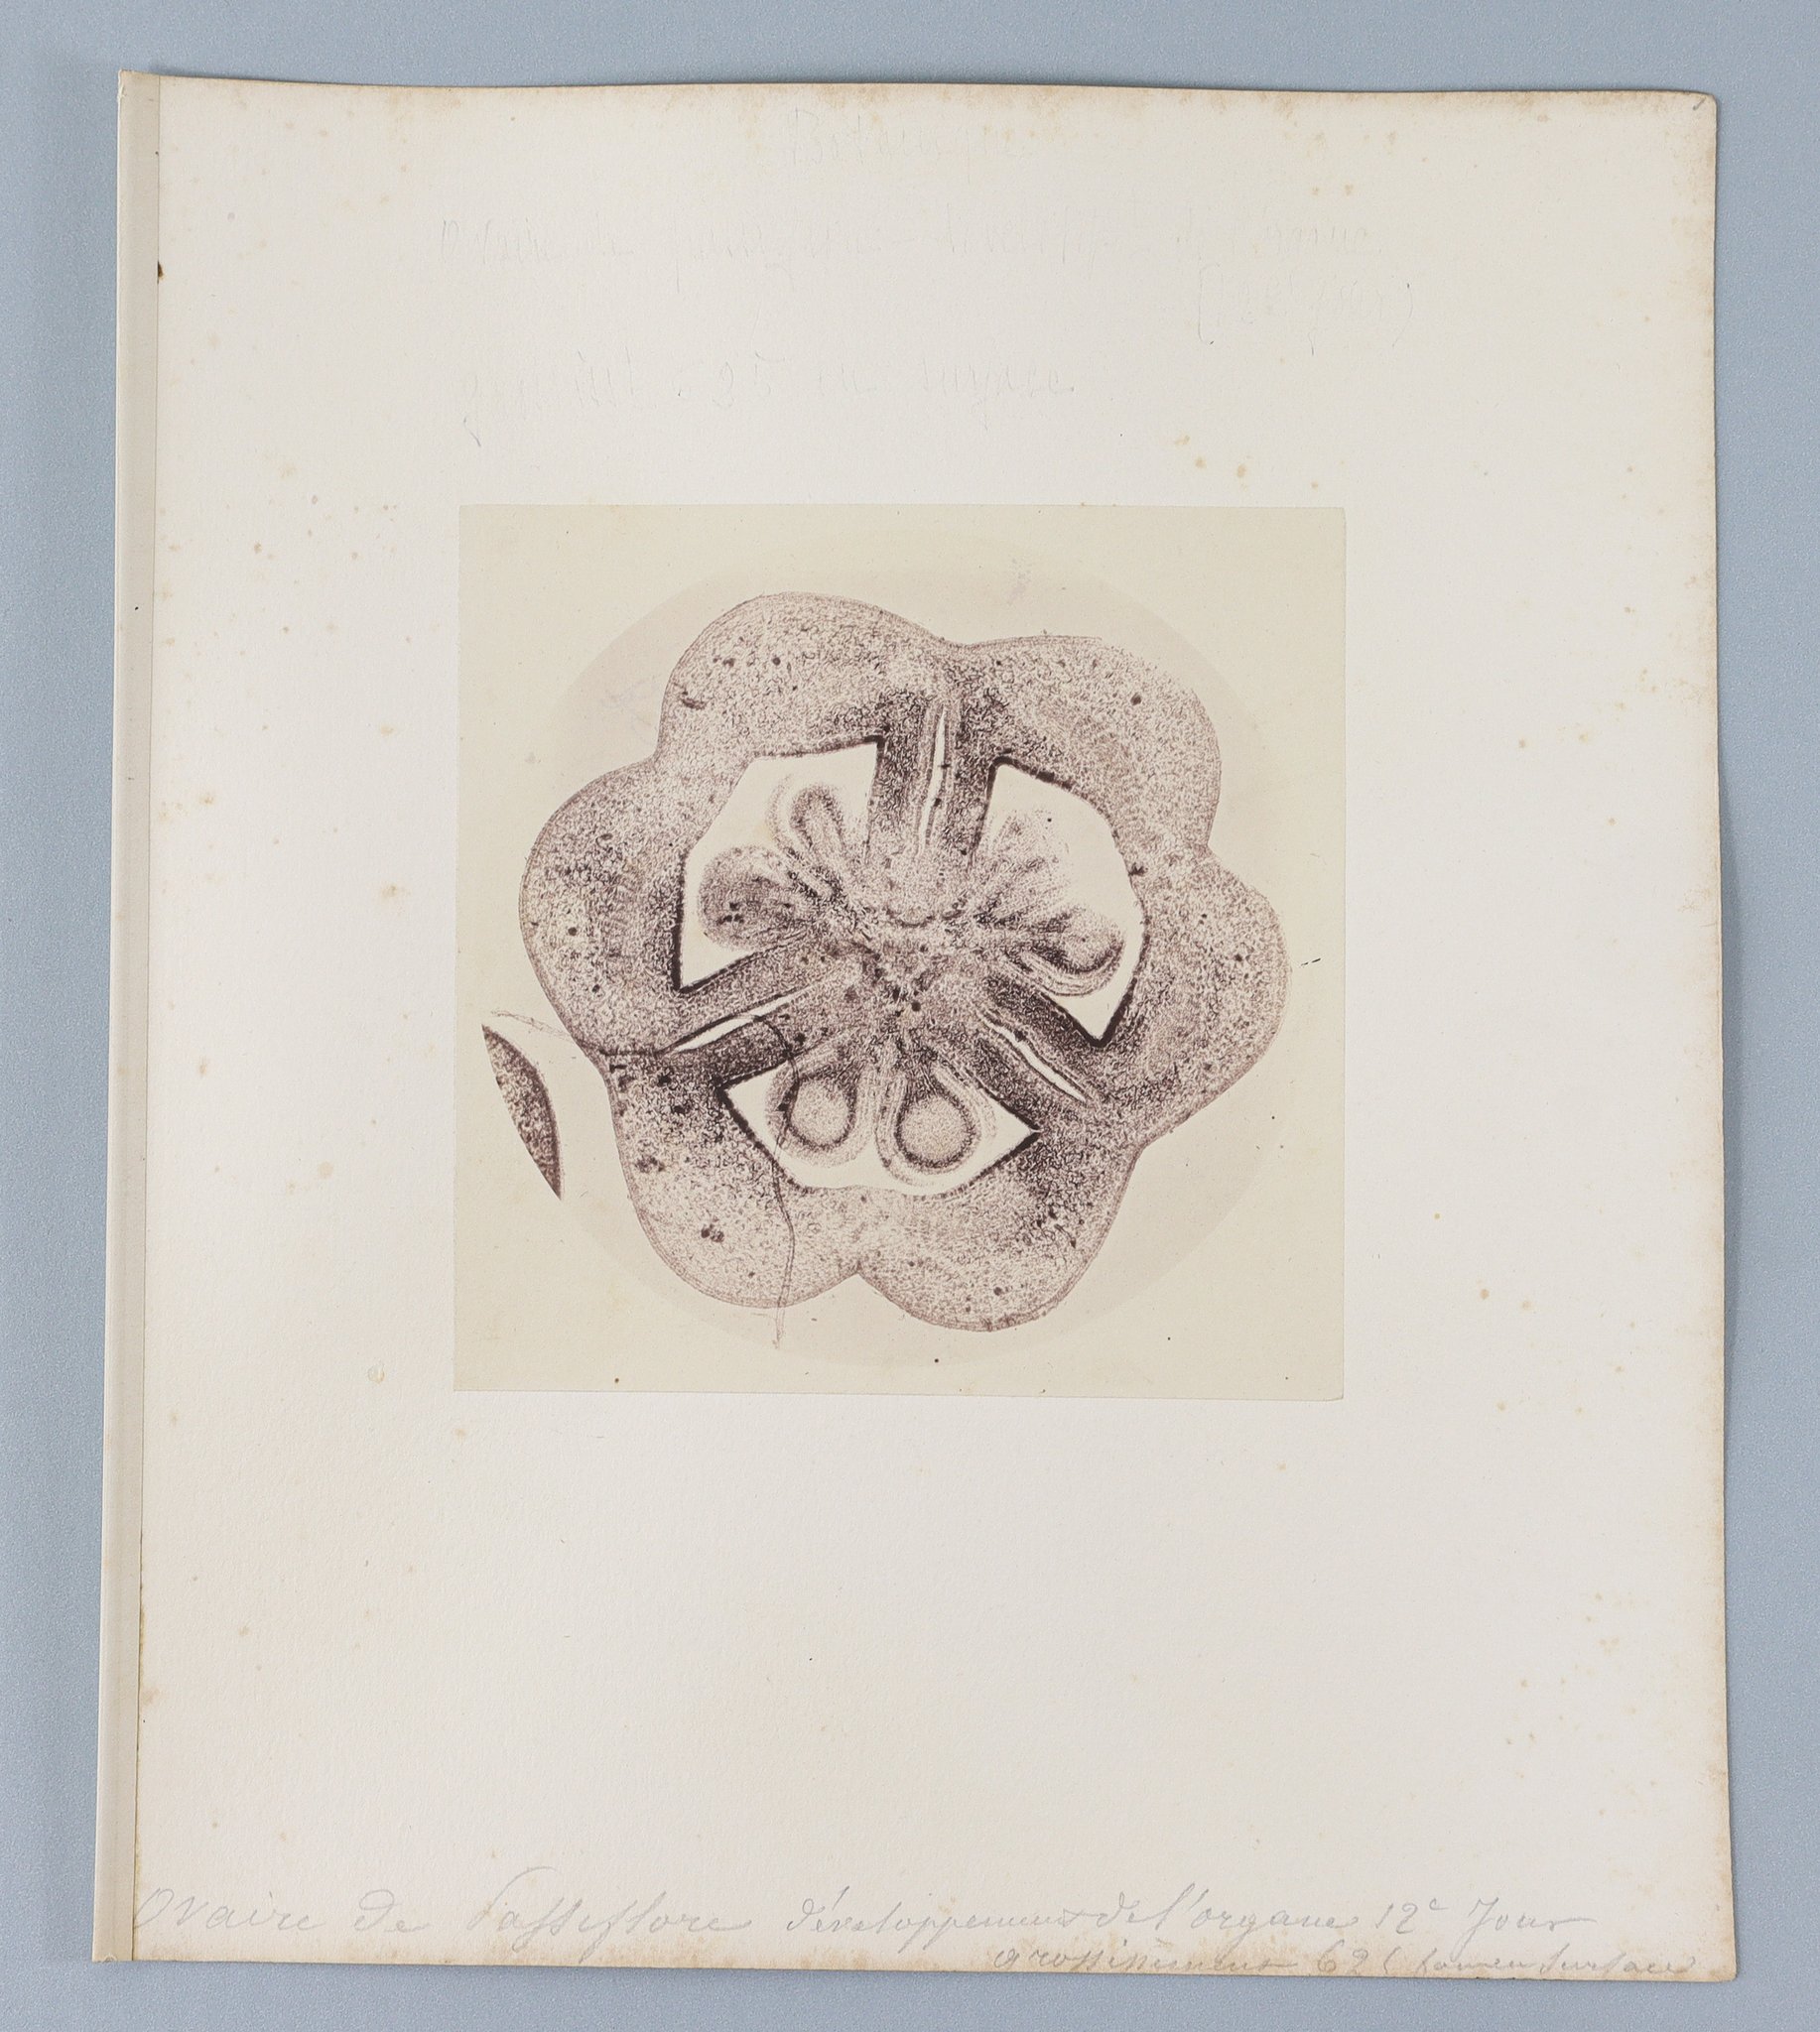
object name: photograph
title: [Untitled]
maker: auguste-adolphe bertsch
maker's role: artist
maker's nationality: french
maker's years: 1813-1871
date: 1853-1857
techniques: salted paper print